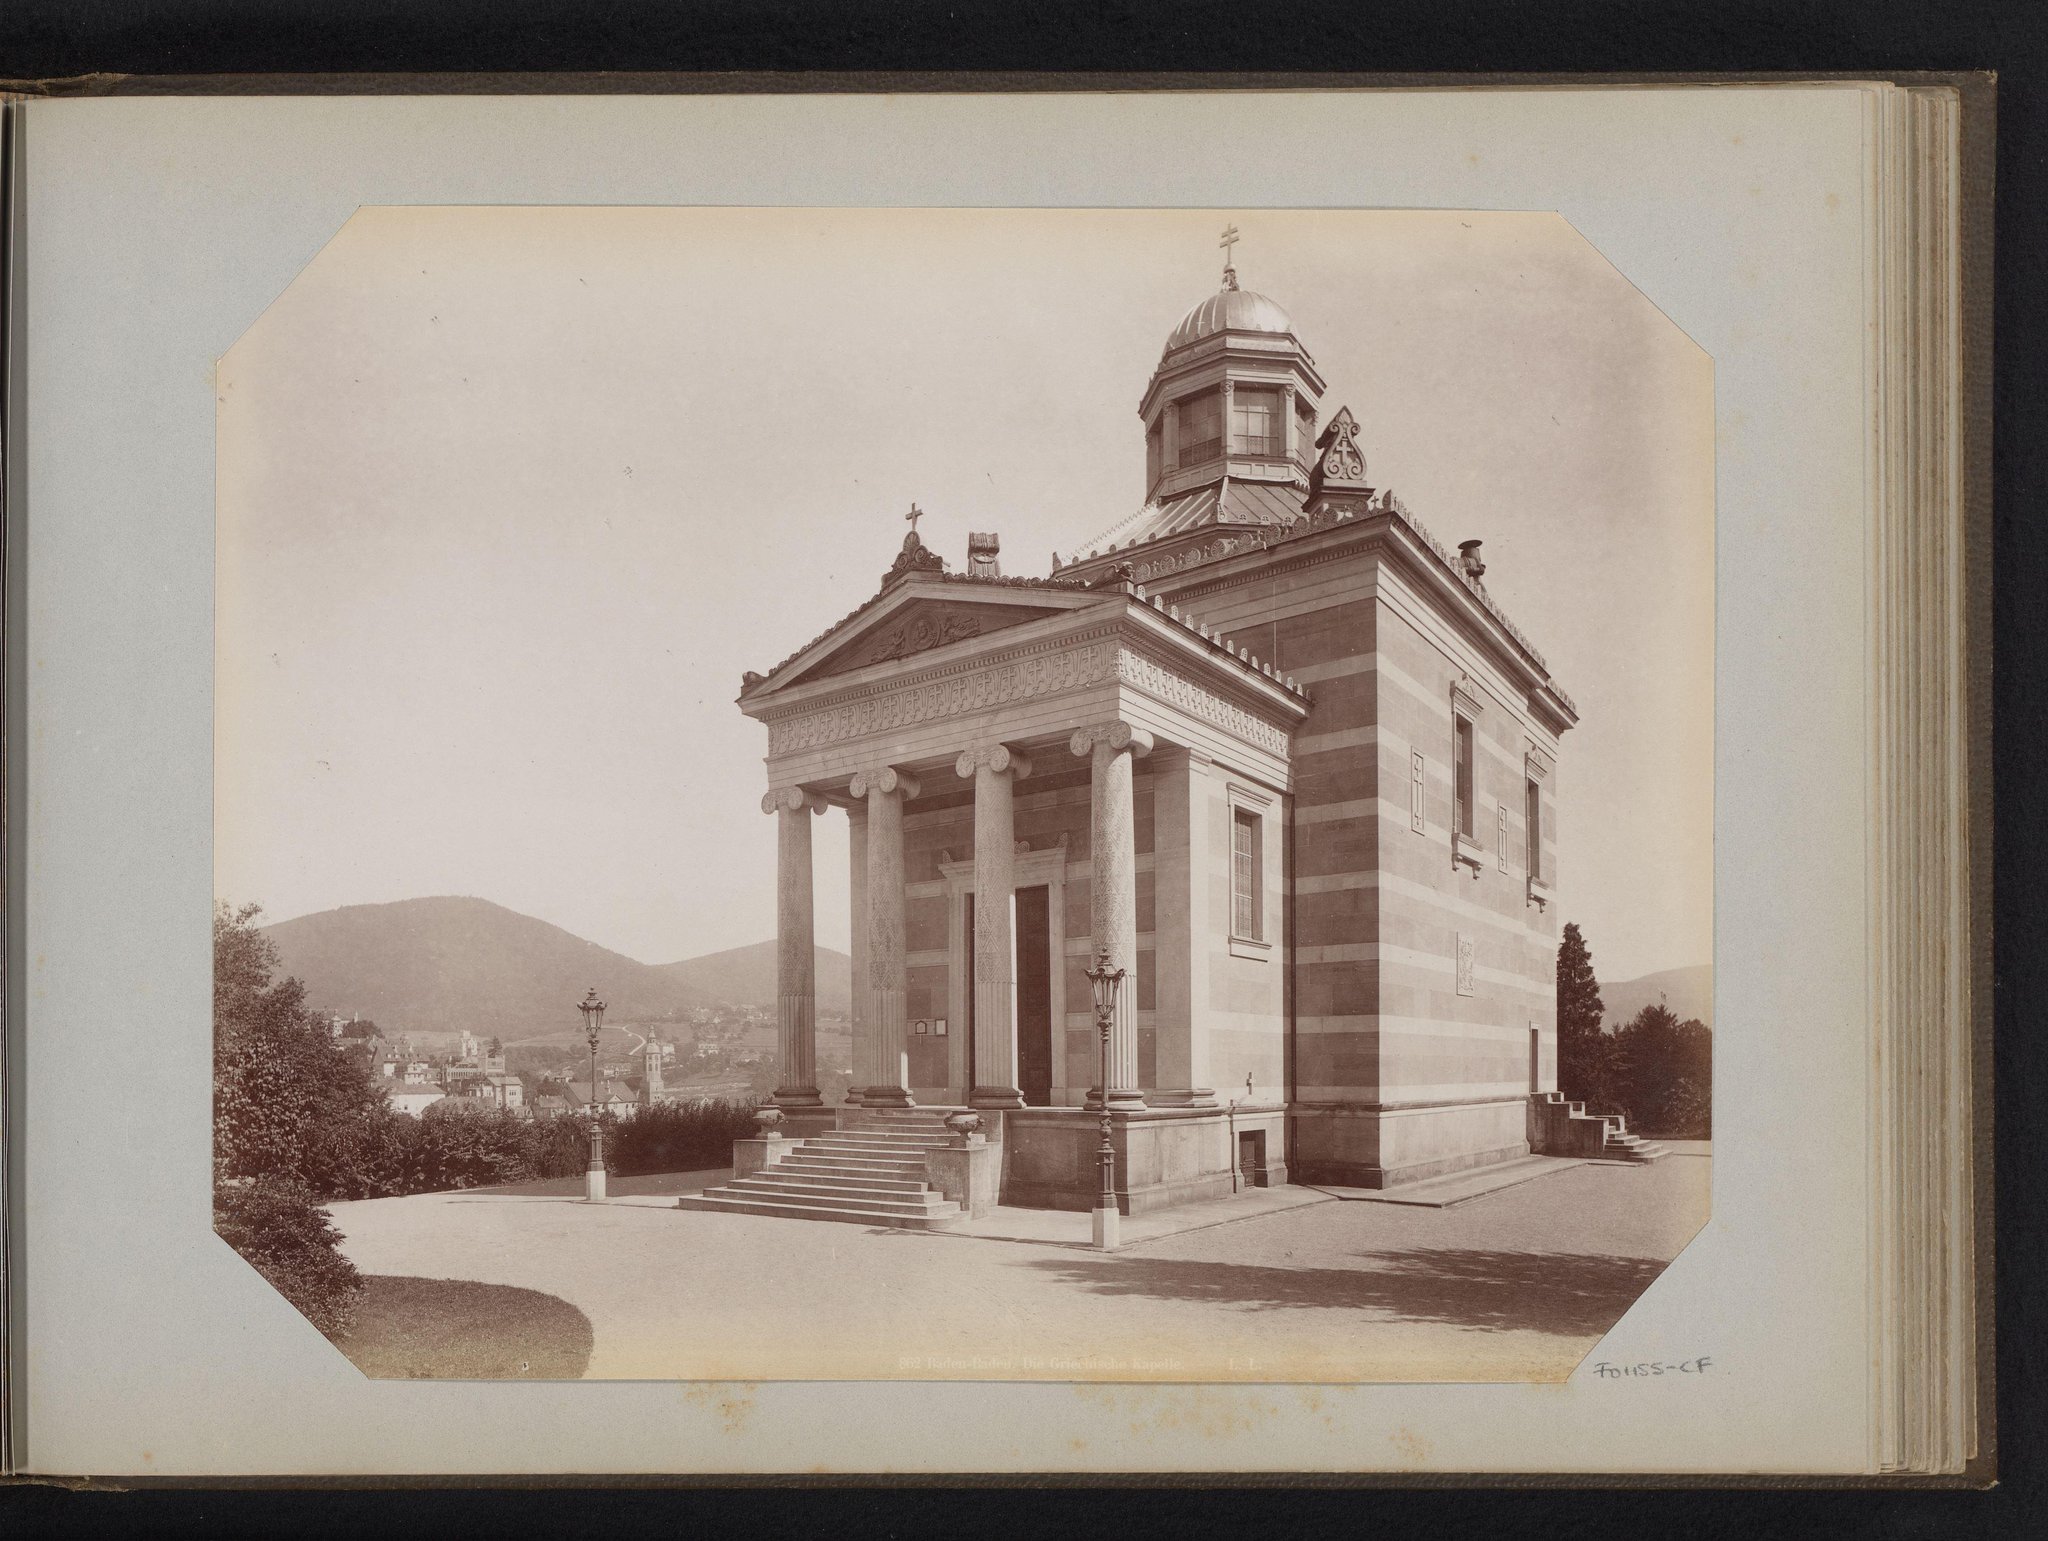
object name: photograph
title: Gezicht op de Stourdza-Kapelle te Baden-Baden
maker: ll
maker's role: fotograaf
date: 1890-1899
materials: photographic support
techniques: albumen print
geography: baden-baden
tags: orthodox churches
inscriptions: inscription: ‘862 Baden-Baden Die Griechische Kapelle. L.L.’